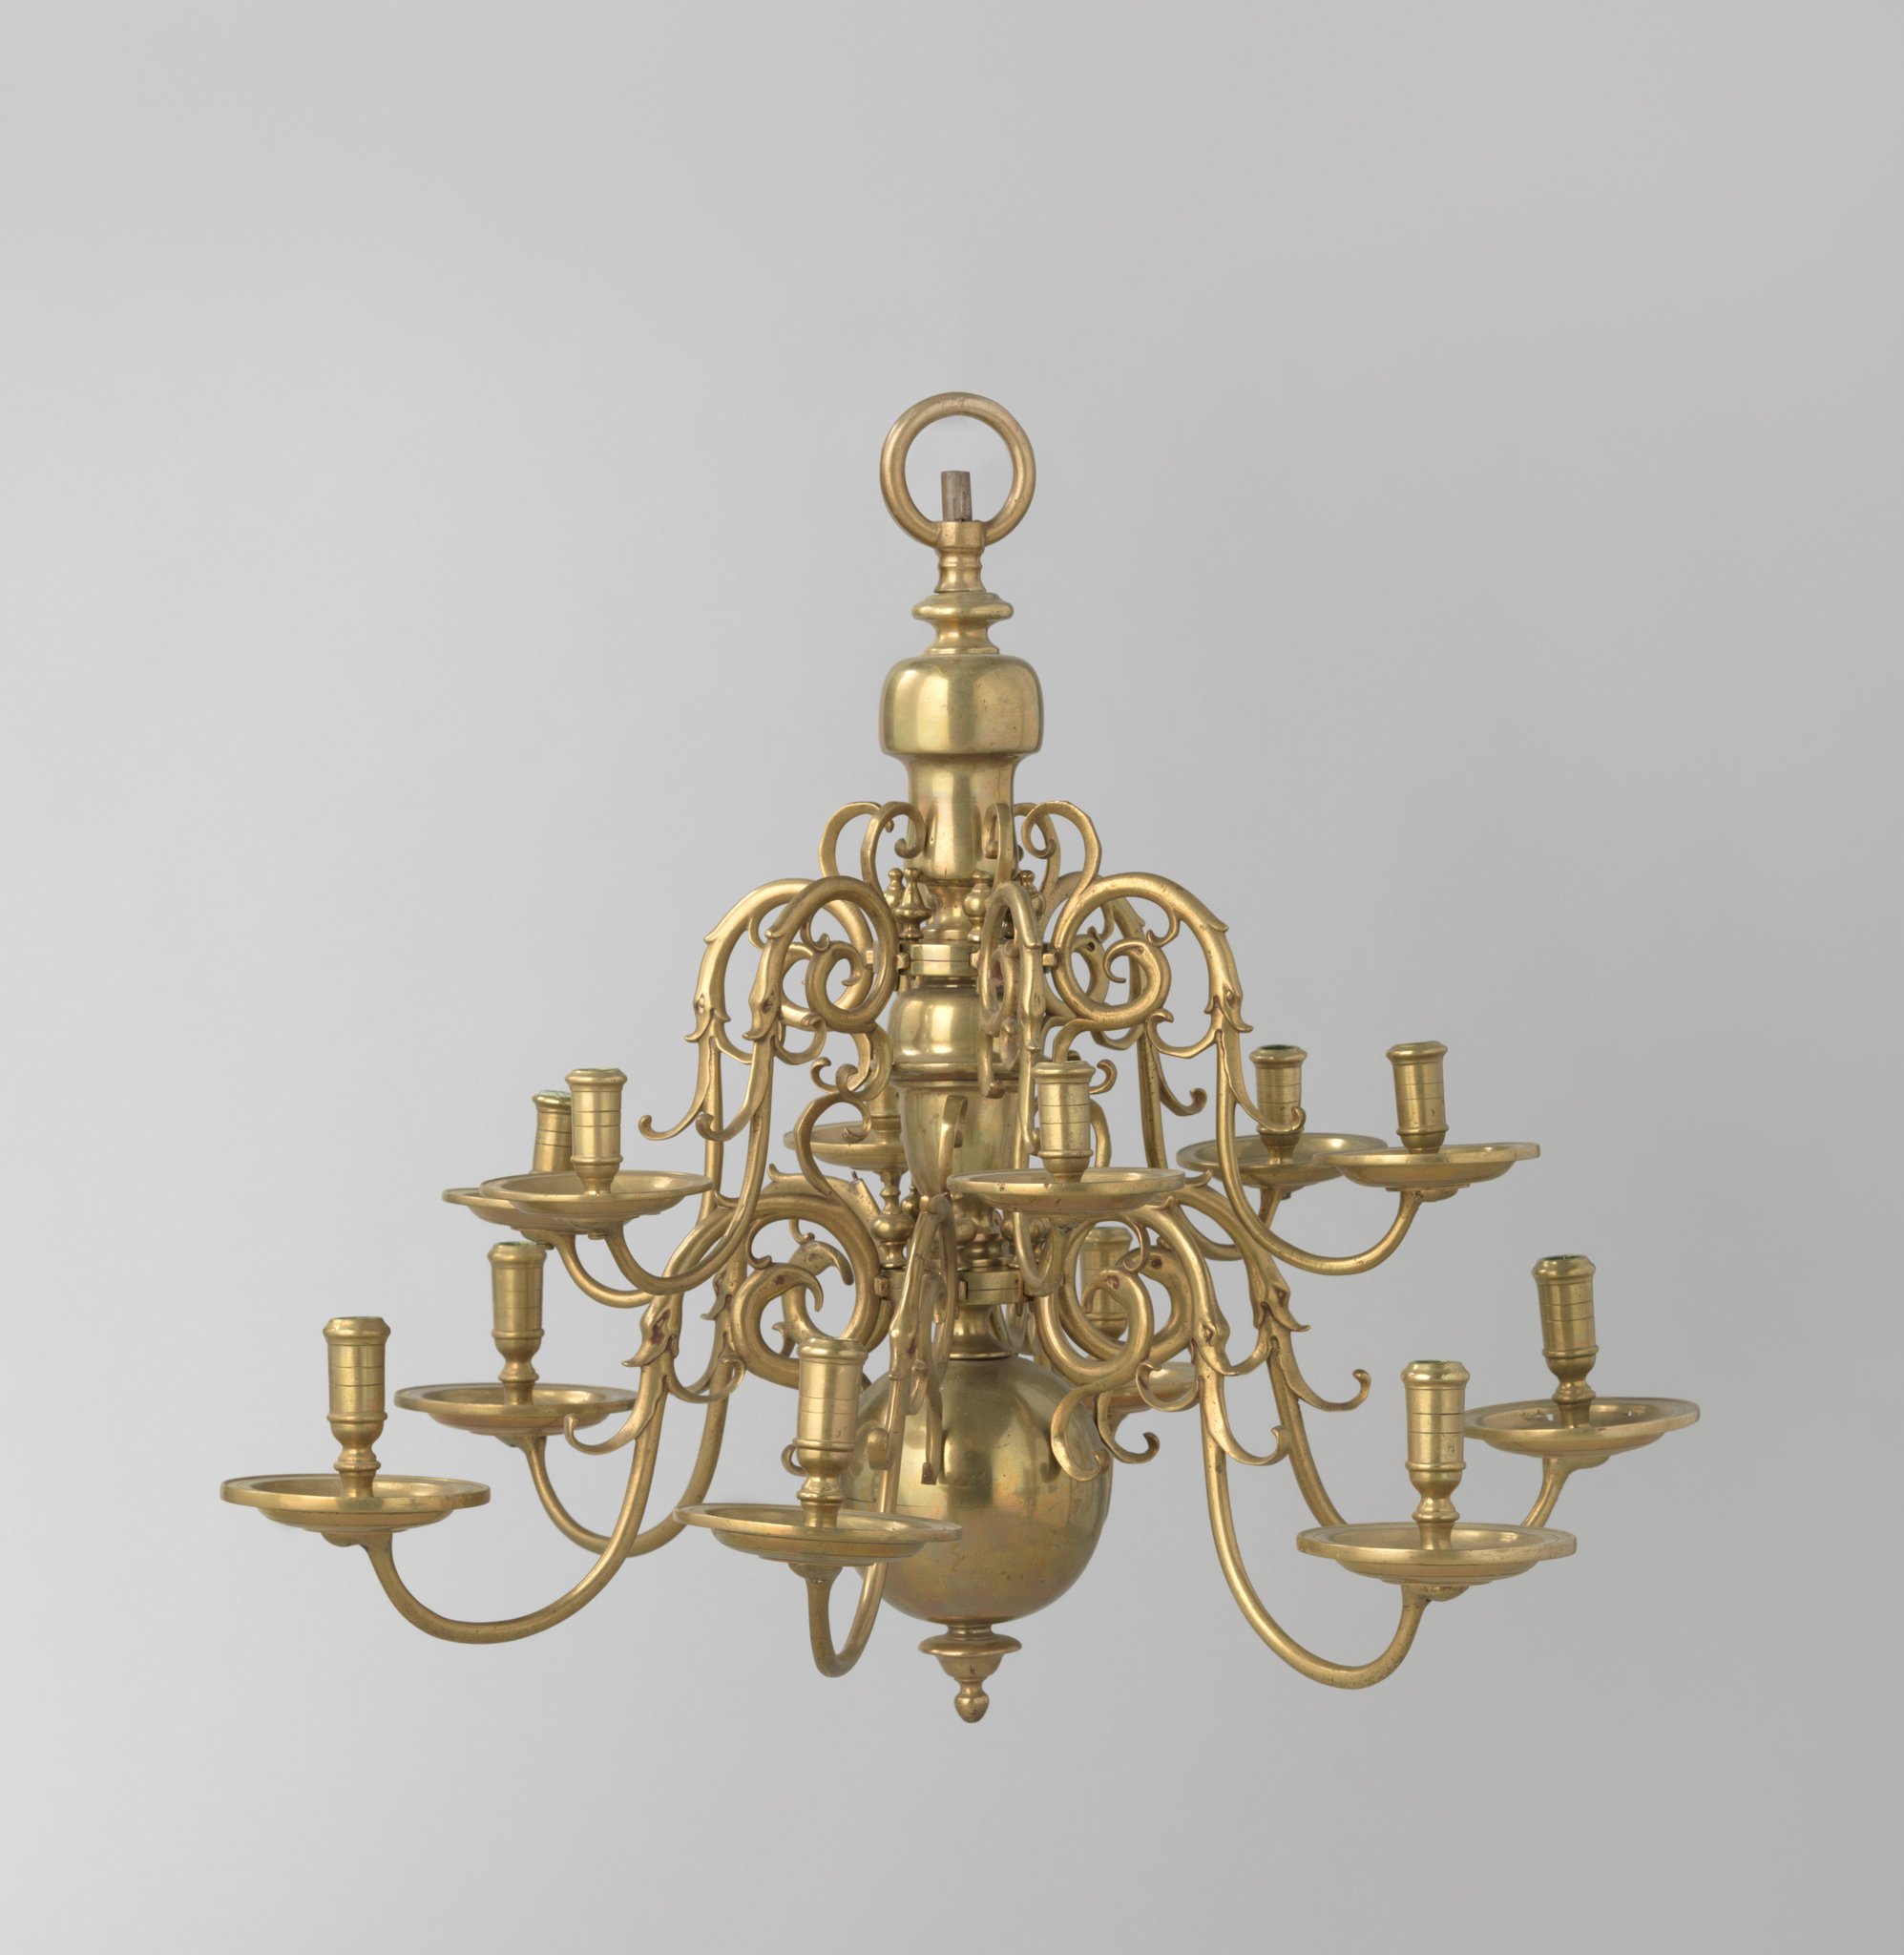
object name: chandelier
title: Arm met kaarsenhouder van kaarsenkroon van twee hoogten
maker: Anonymous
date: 1800-1875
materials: brass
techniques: casting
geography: netherlands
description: Kaarsenarm behorende bij een messing kaarsenkroon van twee hoogten. De S-vormige arm heeft een krul bij de aanzet, halverwege een dolfijnenkop en gaat naar buiten toe over in het platte verdikking met een schroefgat. Daarin is de kaarsenhouder met de vetvanger vastgezet. De vetvanger is aan de onderzijde geribd geprofileerd rond de opening en heeft een naar onder en naar boven toe iets uitstekend randje en is versierd met gegroefde forse ringen. De cylindrische kaarsenhouder heeft een geprofileerde en een weinig uitstekende rand, twee gegroefde ringen, een rib en een geprofileerd holrond onderstuk, dat overgaat in een uitsteeksel met een schroefdraad met een centergat. Dit is de derde arm van de bovenste standring, genummerd met 3 ronde punten.